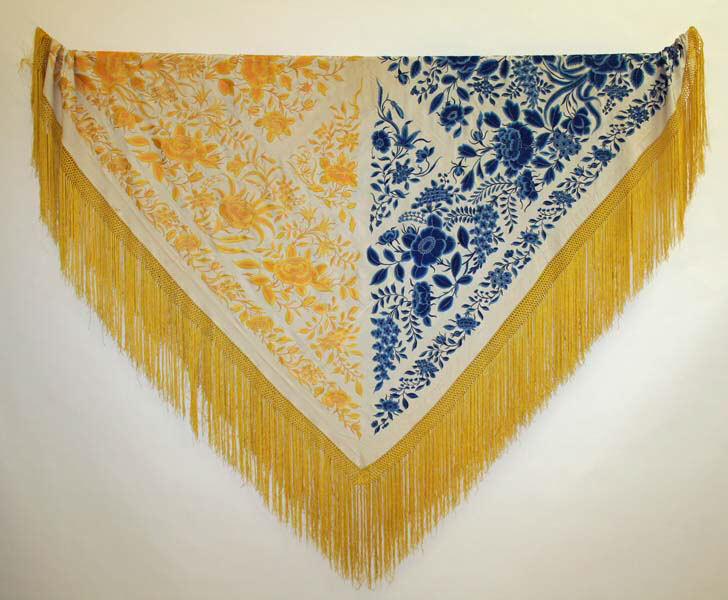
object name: shawl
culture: chinese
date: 1850-1900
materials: silk